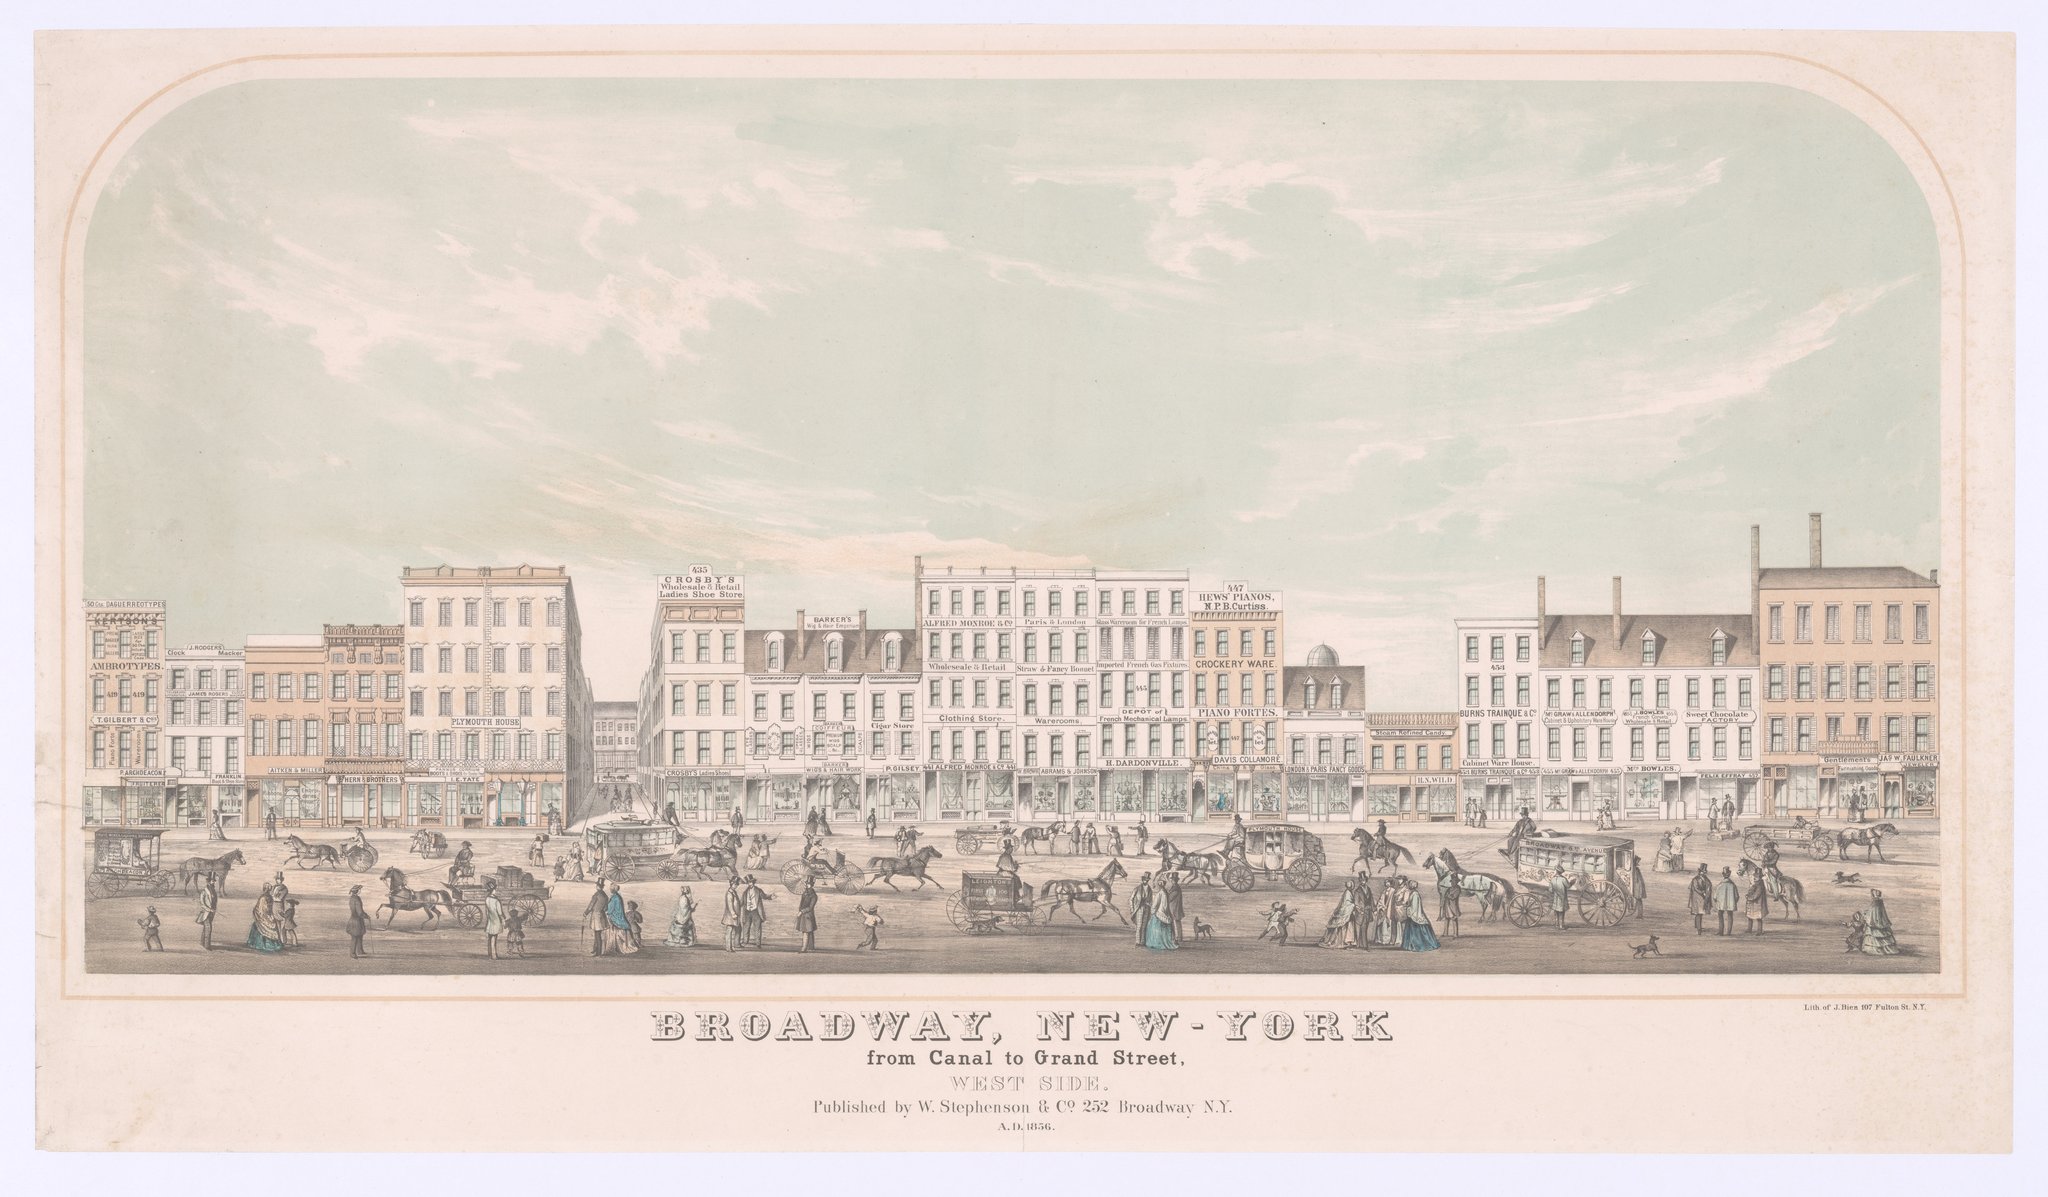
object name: print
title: Broadway, New-York from Canal to Grand Street, West Side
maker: julius bien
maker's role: lithographer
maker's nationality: american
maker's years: 1826-1909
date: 1856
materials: stone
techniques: hand coloring, lithograph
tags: buildings,cities,carriages,new york city